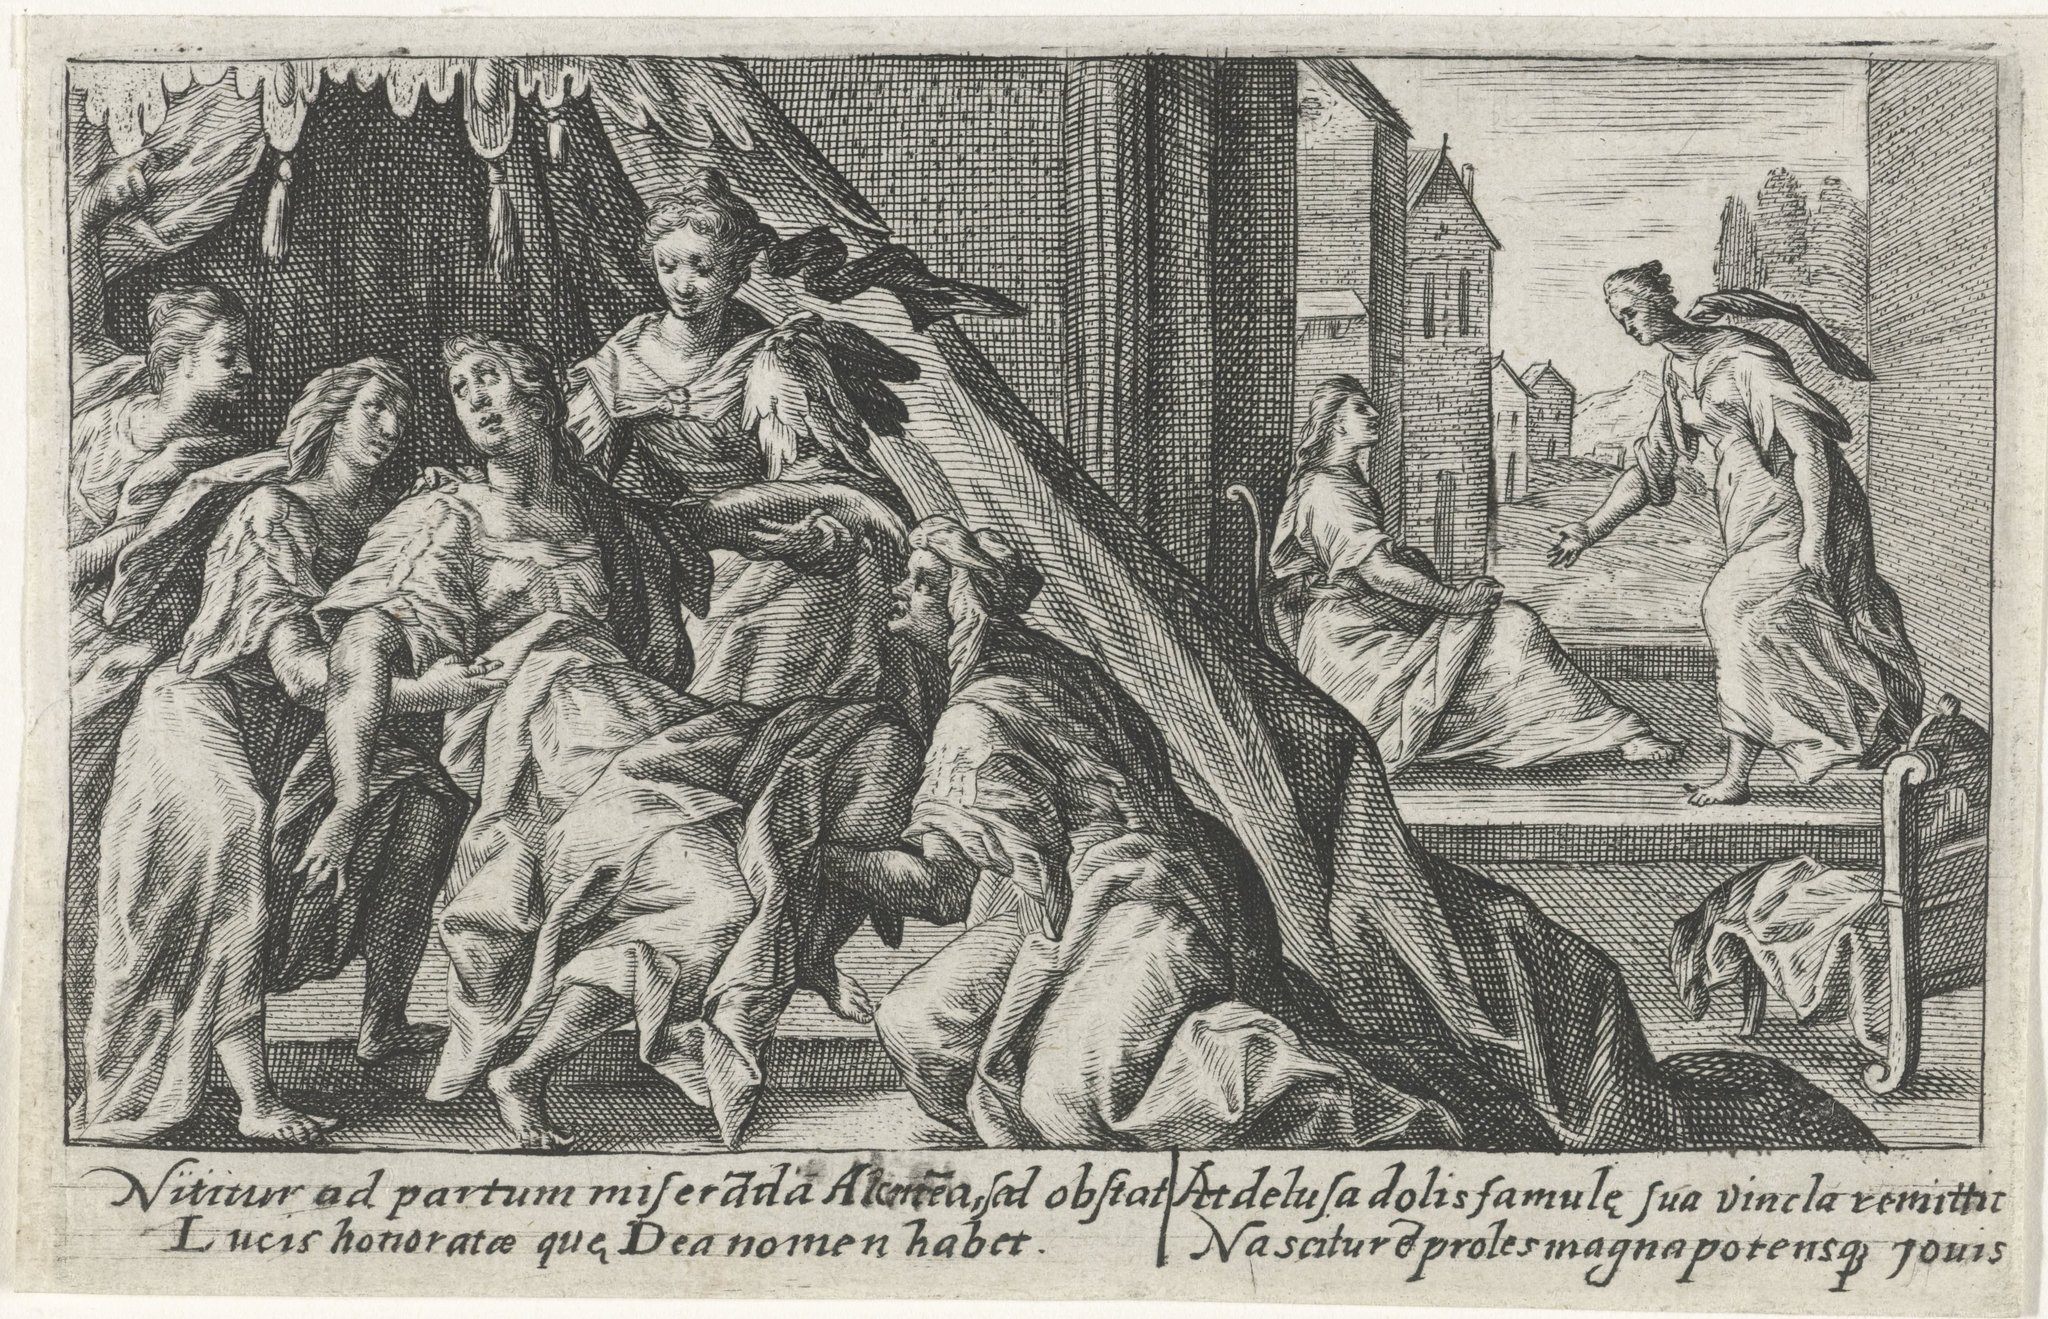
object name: print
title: Metamorfosen van Ovidius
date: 1602-1607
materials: paper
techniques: engraving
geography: cologne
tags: birth of hercules and his twin brother iphicles; juno delays the birth by sitting outside alcmene's door with crossed knees and fingers (+ variant)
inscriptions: collector's mark: Lugt 2228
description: Alcmene baart Hercules en diens tweelingbroer Iphicles. Thebaanse vrouwen spreken haar moed in. Juno vertraagt de geboorte door de beschermgodin Lucina om te kopen. De dienstmeid Galanthis fopt de godin die voor het vertrek zit en redt zo Alcmene. In de marge een vierregelig onderschrift, in twee kolommen, in het Latijn.